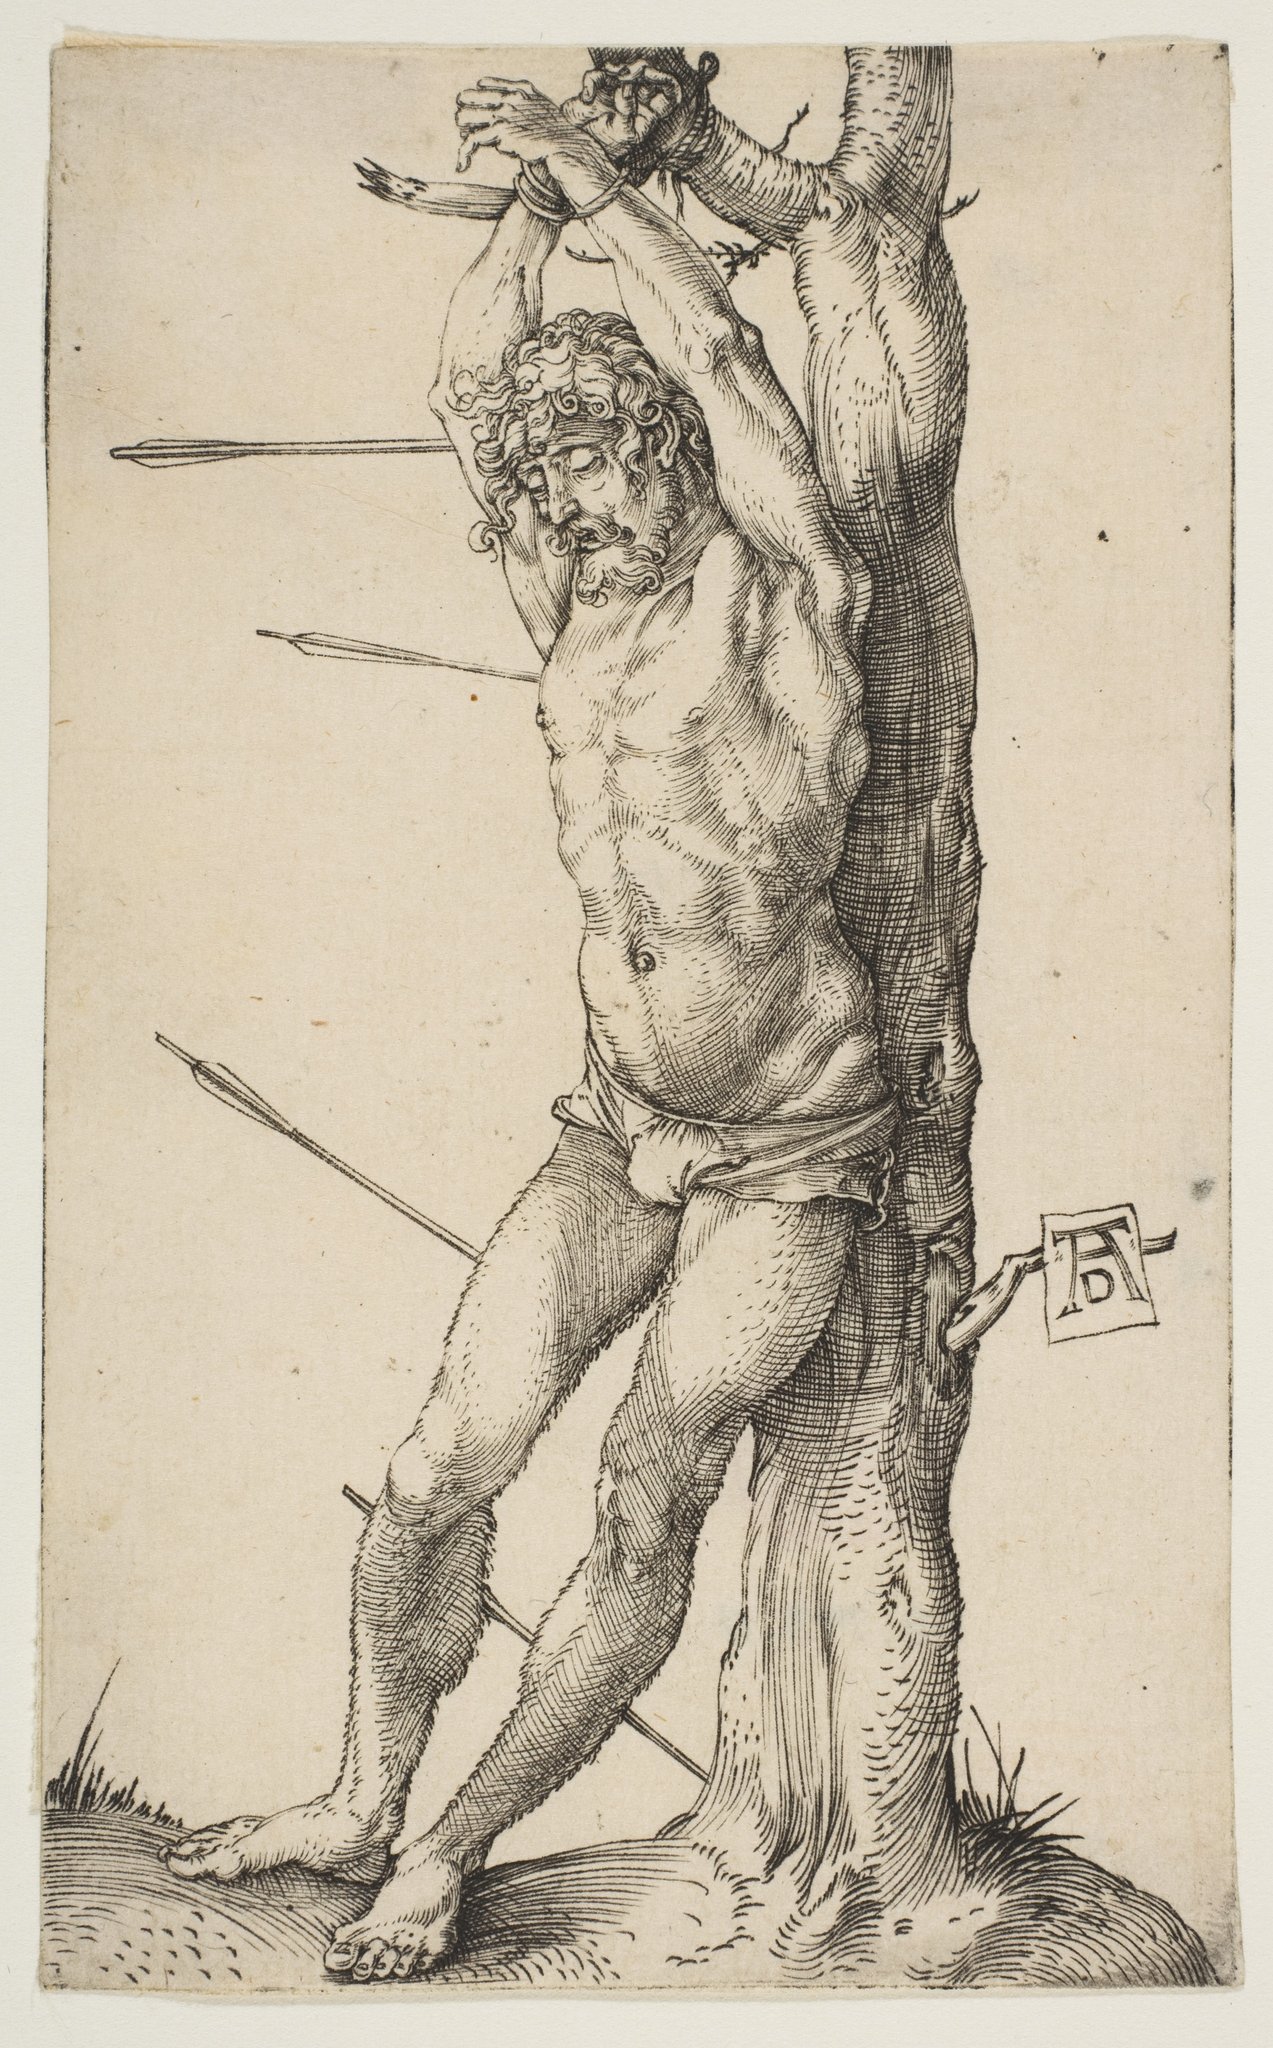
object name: print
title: Saint Sebastian Tied to a Tree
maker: albrecht dürer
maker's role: artist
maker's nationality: german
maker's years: 1471-1528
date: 1501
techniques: engraving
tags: arrows,men,trees,saints